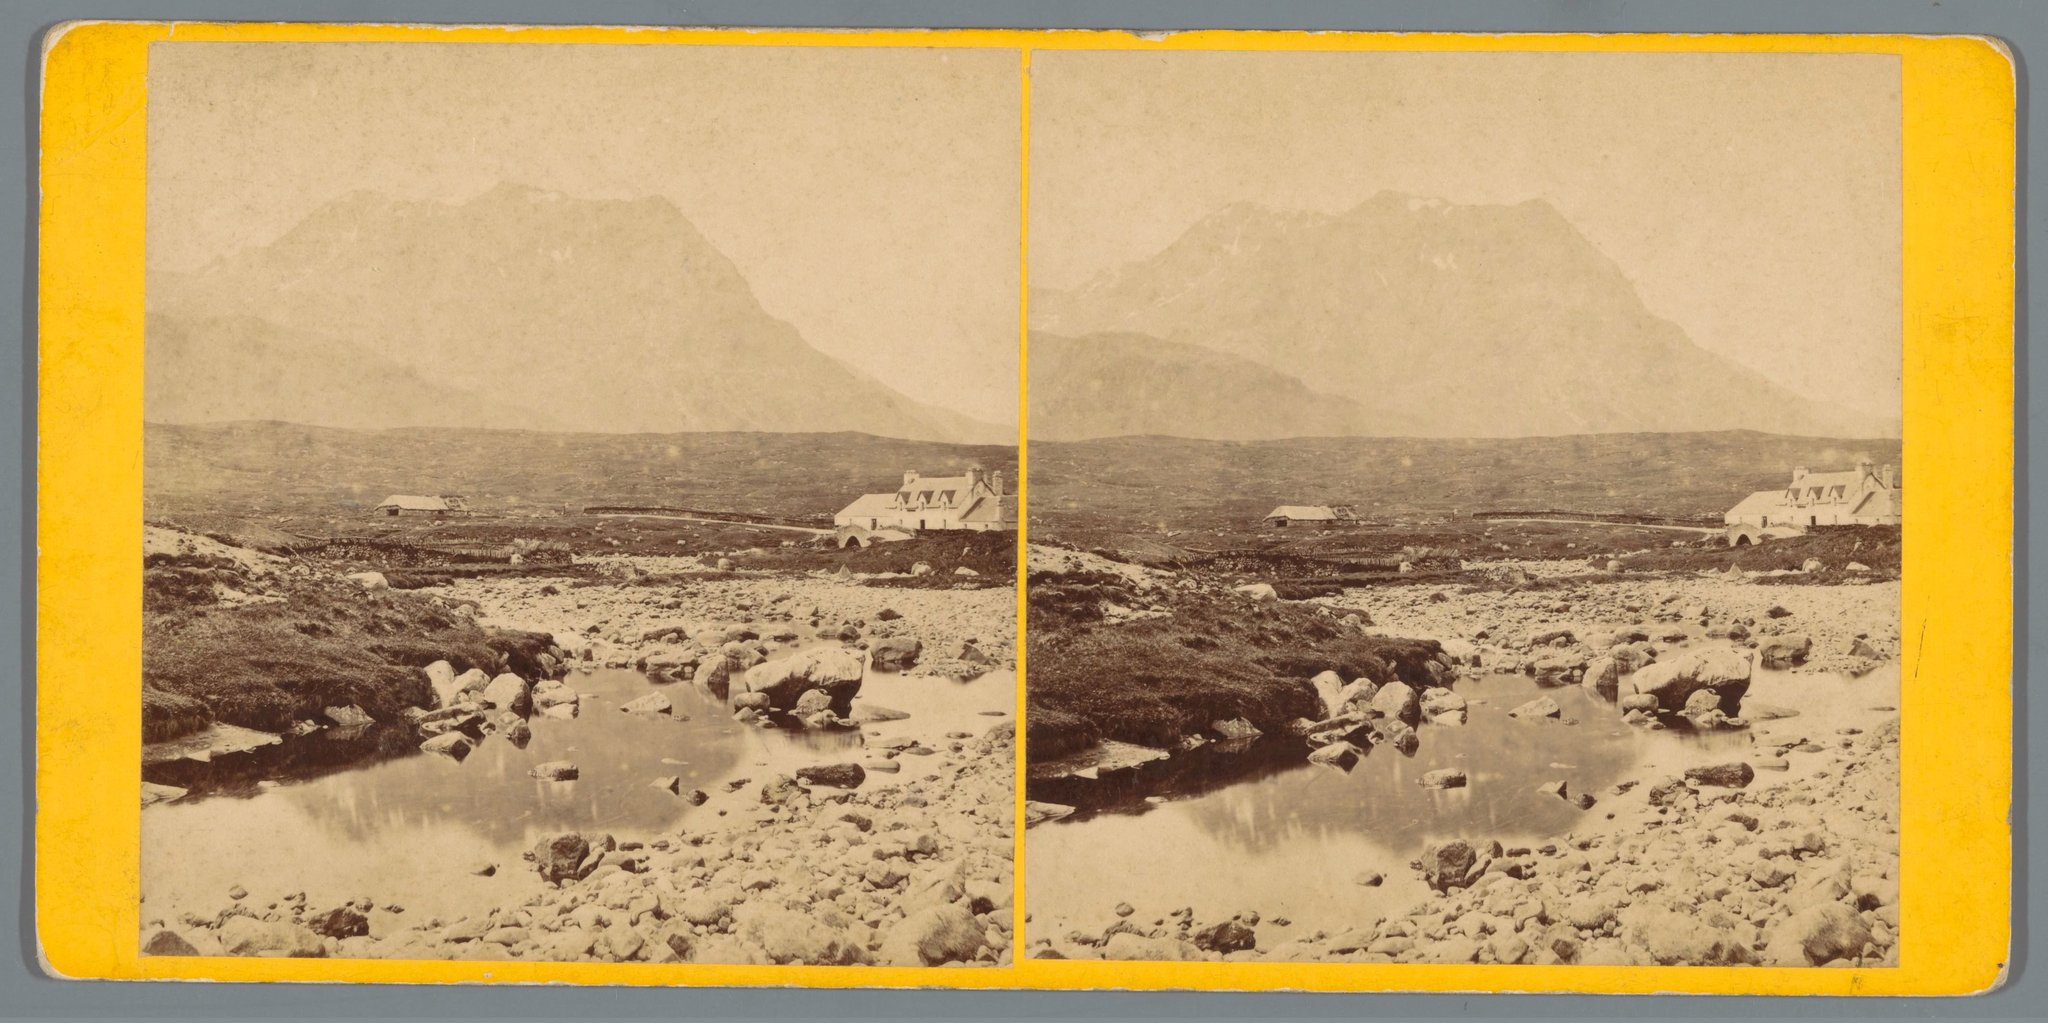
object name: stereograph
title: King’s house, Glencoe – Looking to Craishan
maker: george washington wilson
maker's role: publisher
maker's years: 1823-1893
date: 1860-1865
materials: cardboard, photographic support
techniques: albumen print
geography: aberdeen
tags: schotland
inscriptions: label: ‘G.W. Wilson & Co, Aberdeen No. 1517 King’s house, Glencoe – Looking to Craishan’